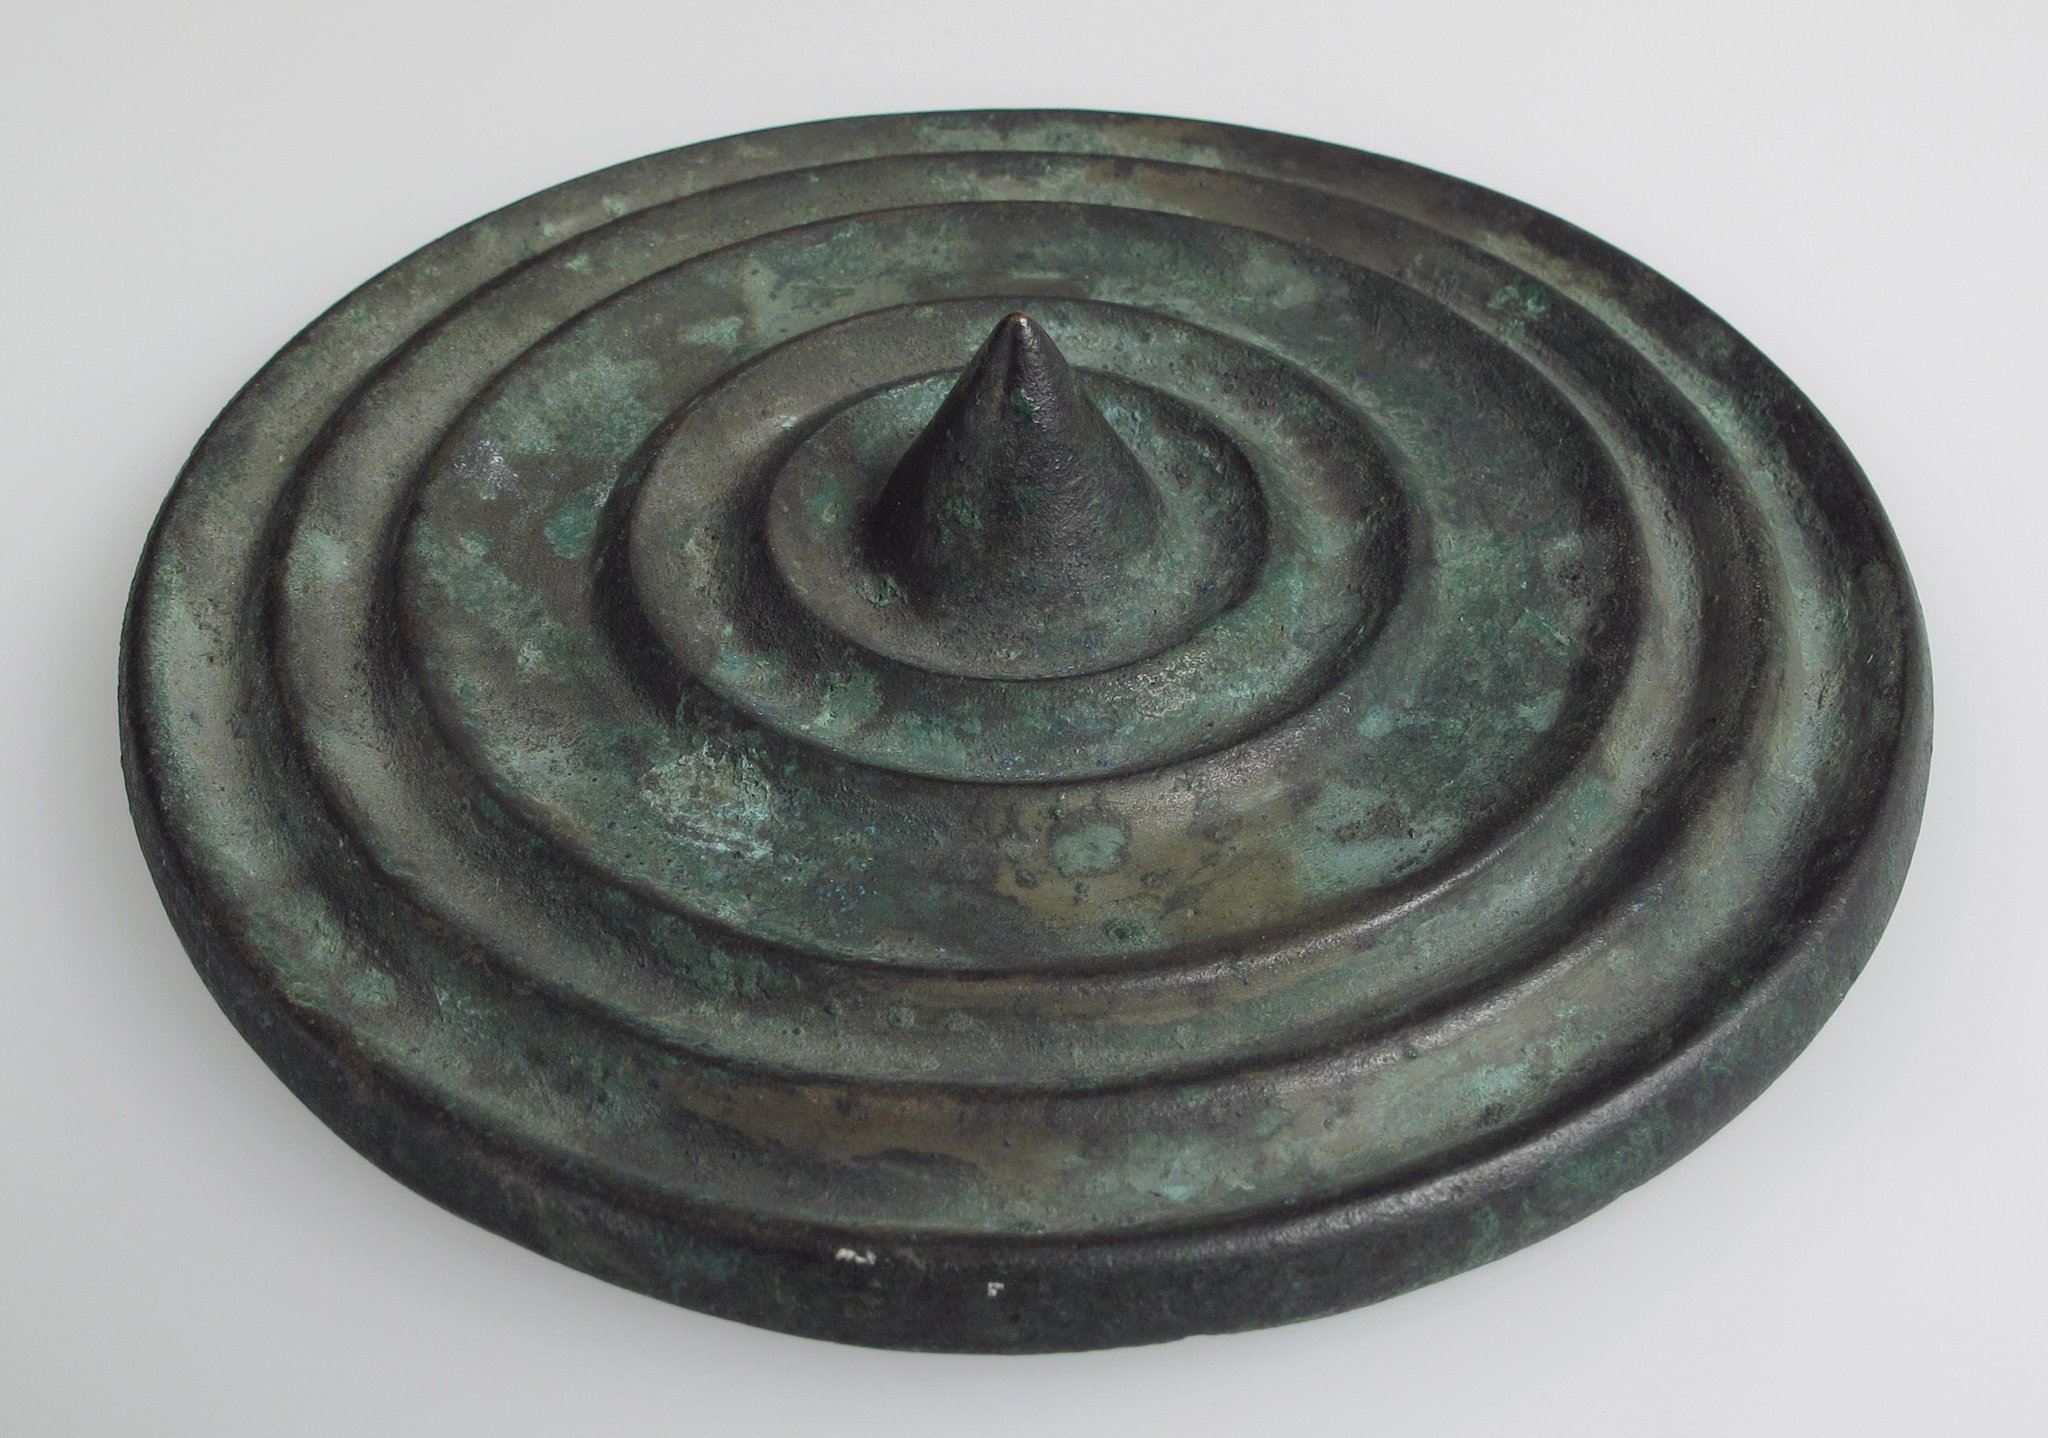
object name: disk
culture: irish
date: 1000 BCE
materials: copper alloy